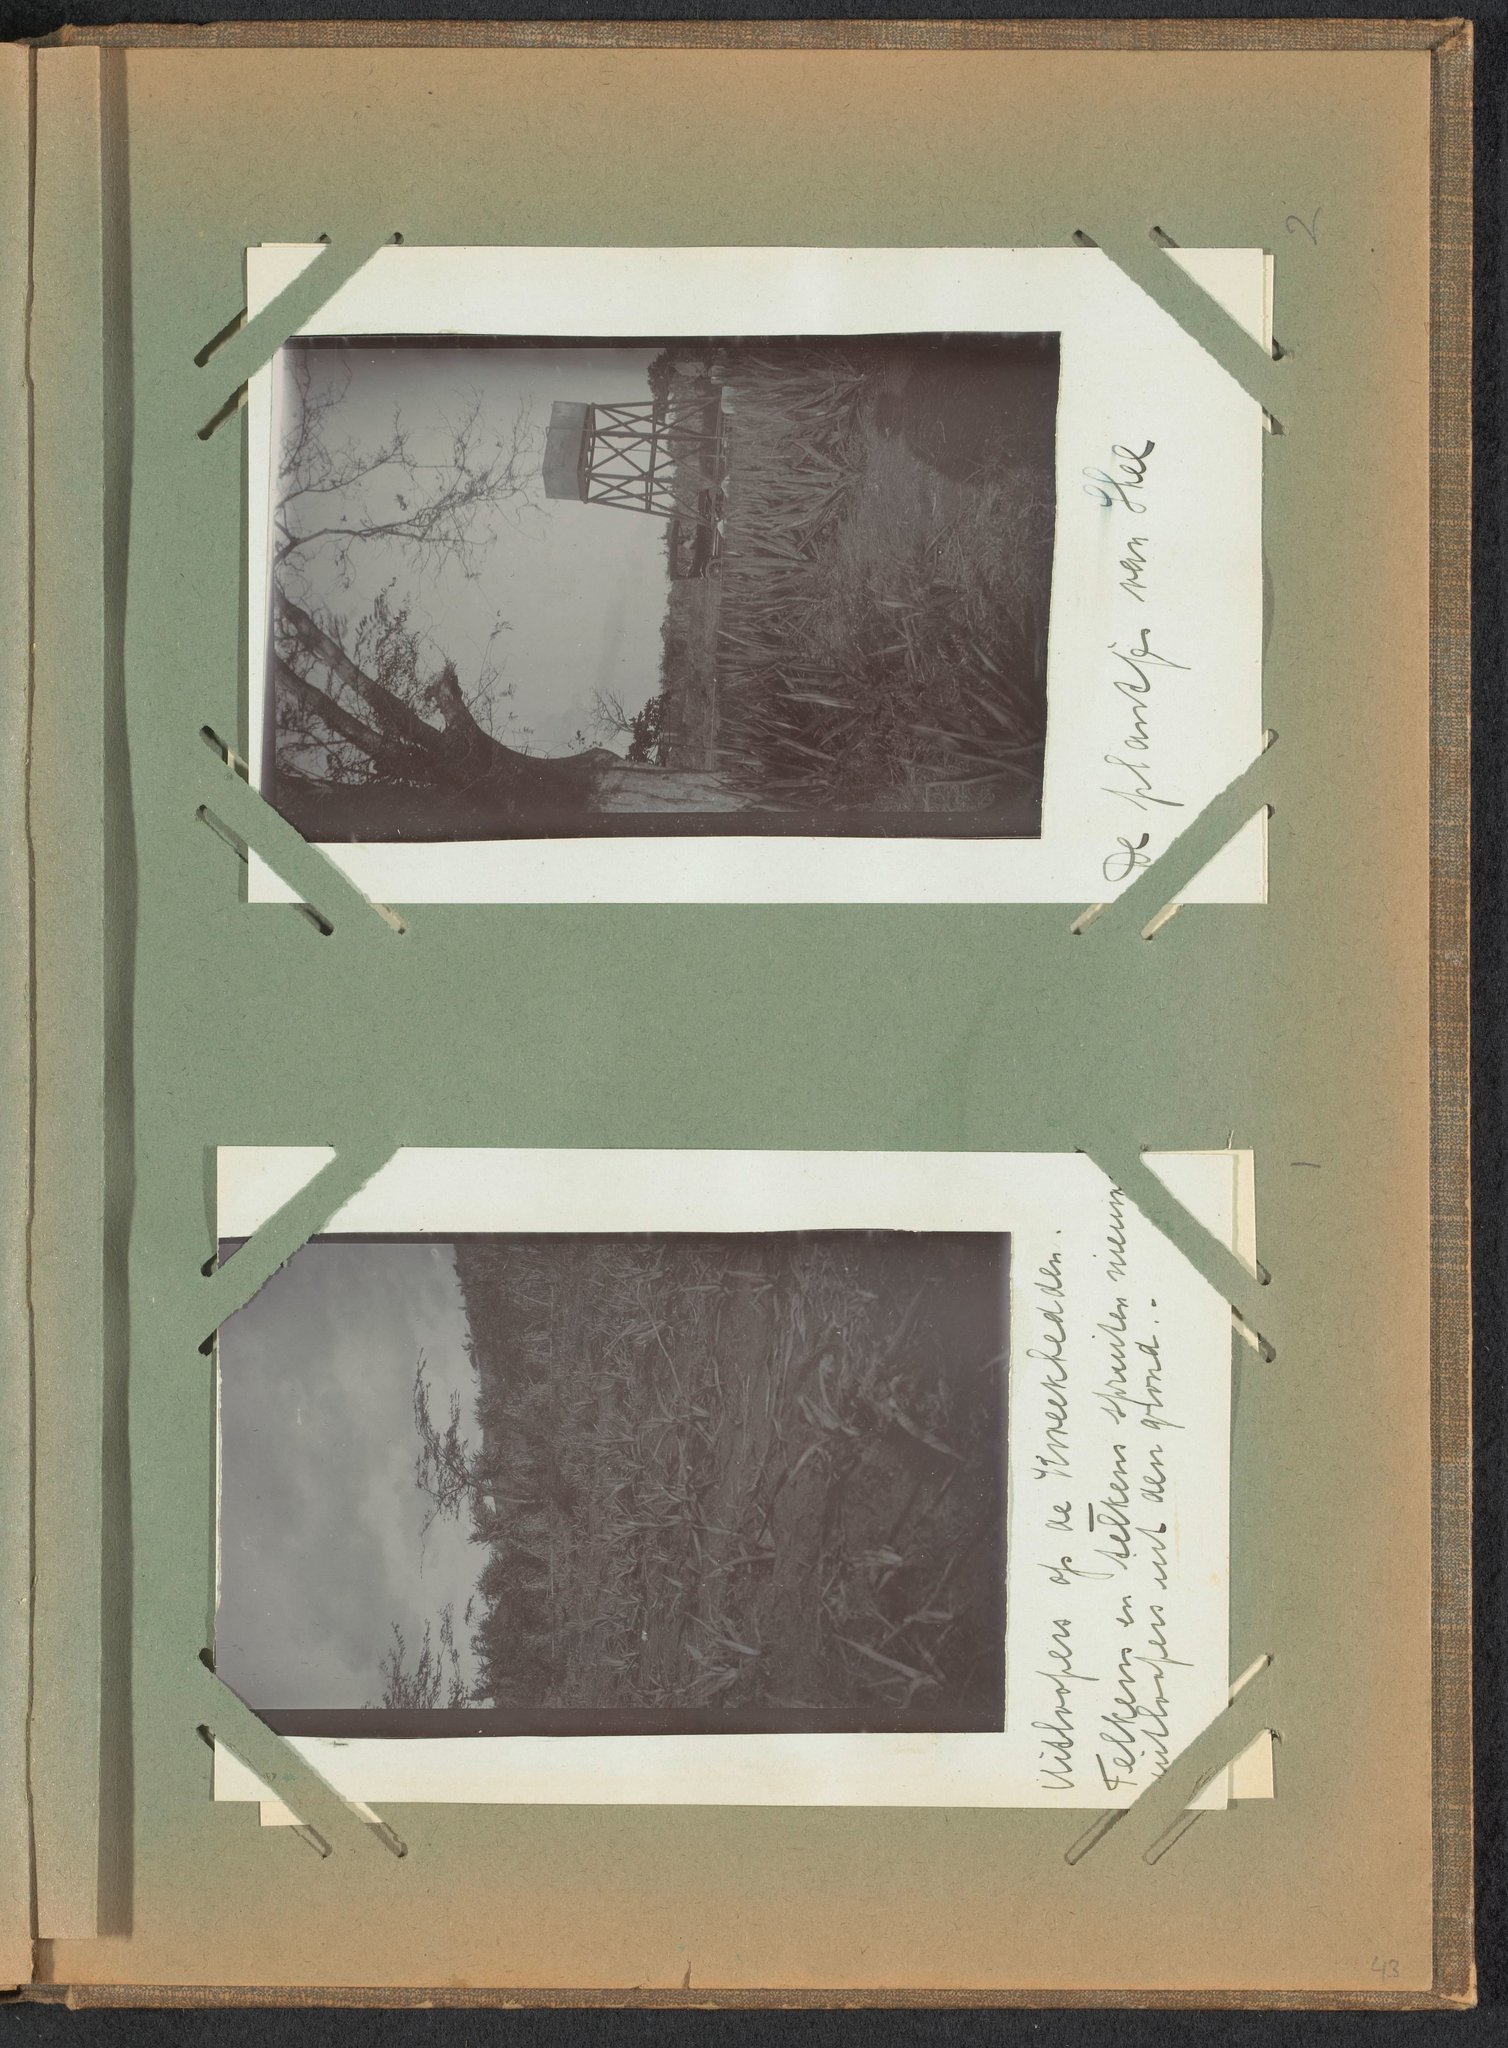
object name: photograph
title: Kweekbedden met sisalplanten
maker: Anonymous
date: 1912-1913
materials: paper, photographic support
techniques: gelatin silver print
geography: curacao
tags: plantation, (non-fruit) products of plants or trees: sisal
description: Kweekbedden met sisalplanten op Plantage Mount Pleasant op Curaçao. Onderdeel van het fotoalbum uit ca. 1912-1913 met 92 foto's van de plantages Peperpot en Dordrecht in Suriname en Mount Pleasant op Curaçao.